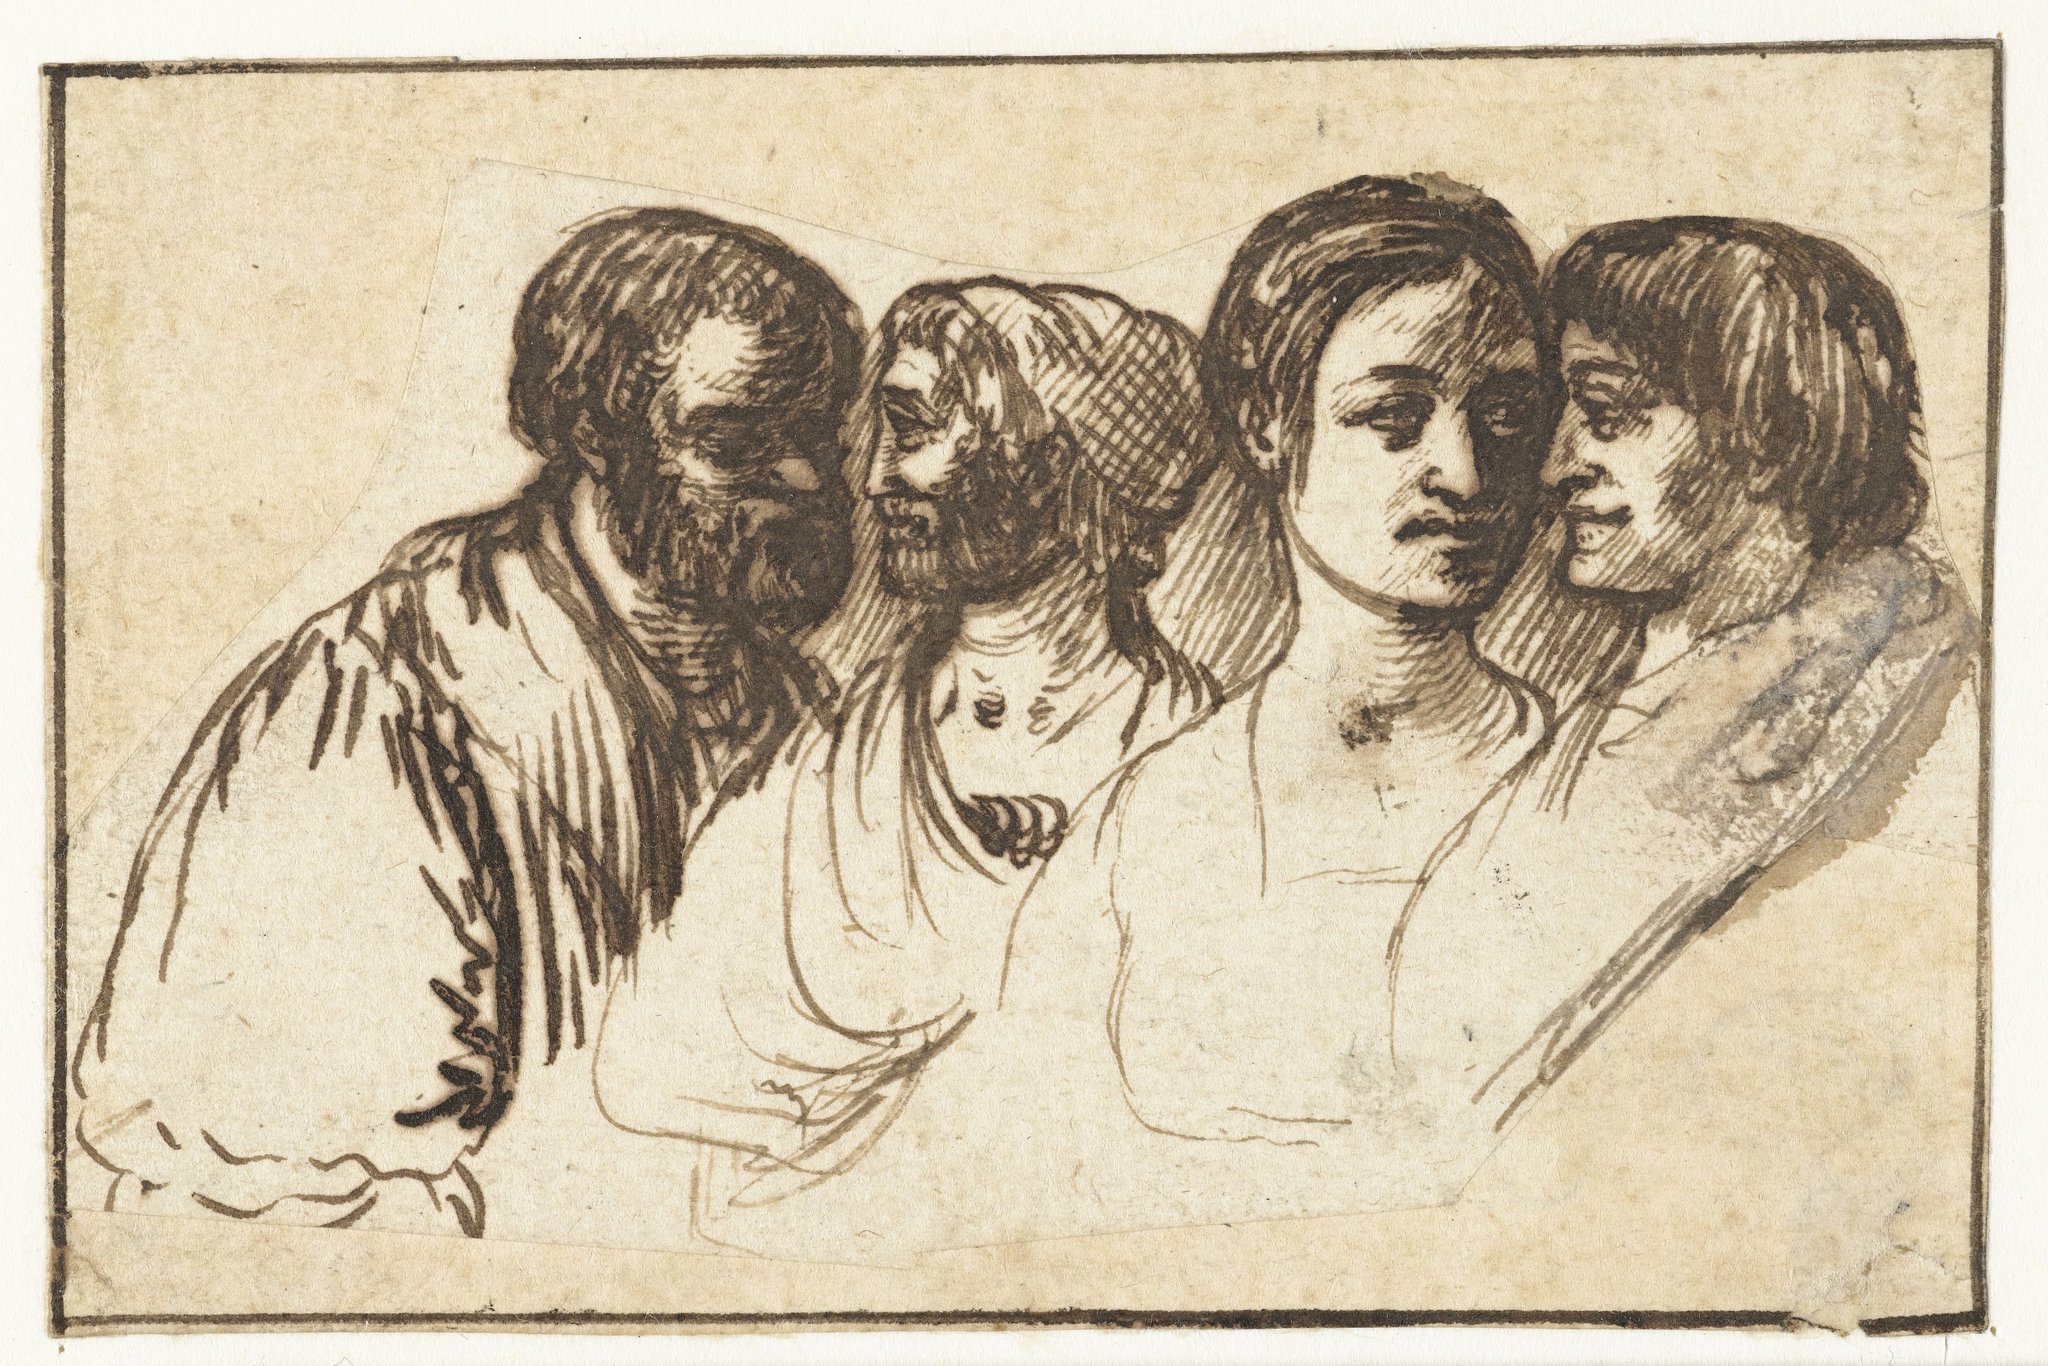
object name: drawing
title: Drie mannen en een vrouw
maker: hendrick goudt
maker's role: draughtsman, print maker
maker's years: 1581-1648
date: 1580-1650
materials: ink, paper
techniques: pen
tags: physiognomy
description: Studieblad van drie mannen en een vrouw.